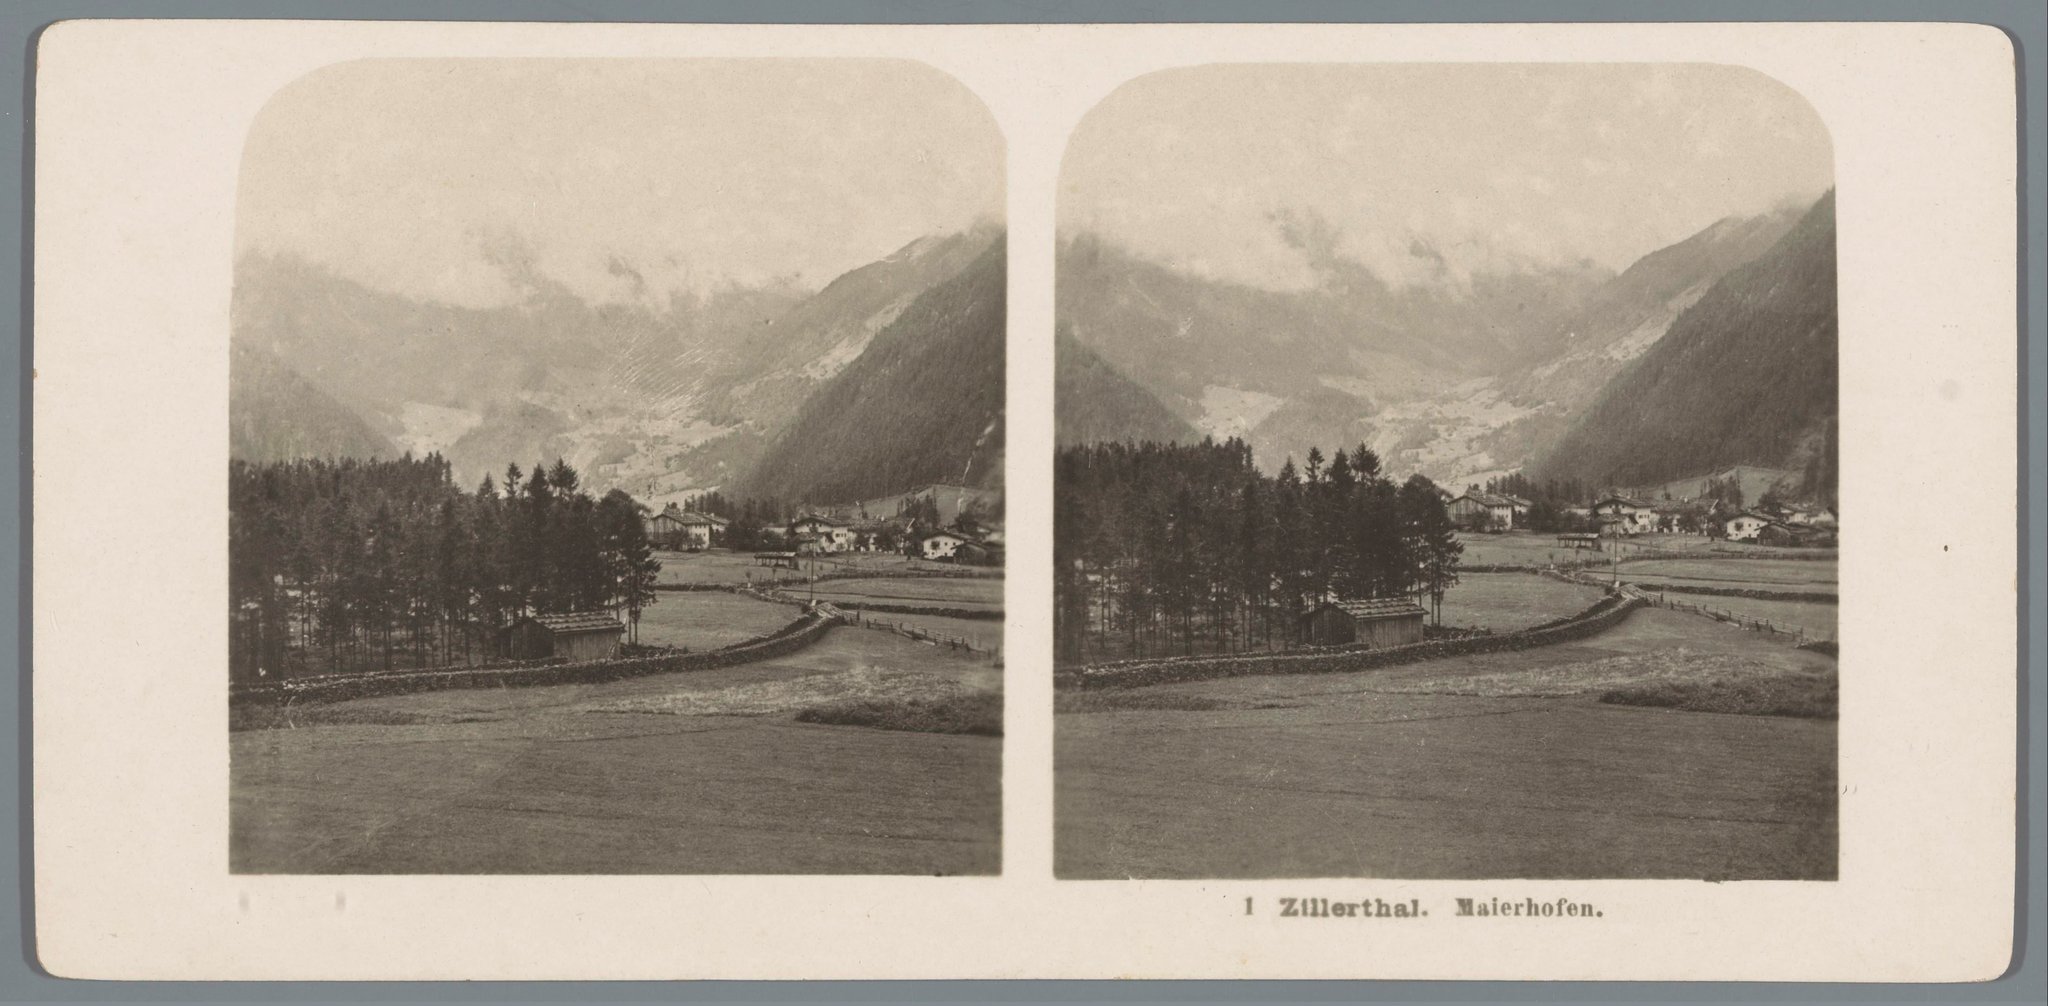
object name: stereograph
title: Gezicht op Mayrhofen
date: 1904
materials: cardboard, photographic support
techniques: gelatin silver print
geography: tirol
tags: city-view in general; 'veduta', mountains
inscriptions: number: ‘1’, inscription: ‘Neue Photographische Gesellschaft A.-G. Steglitz-Berlin 1904.’